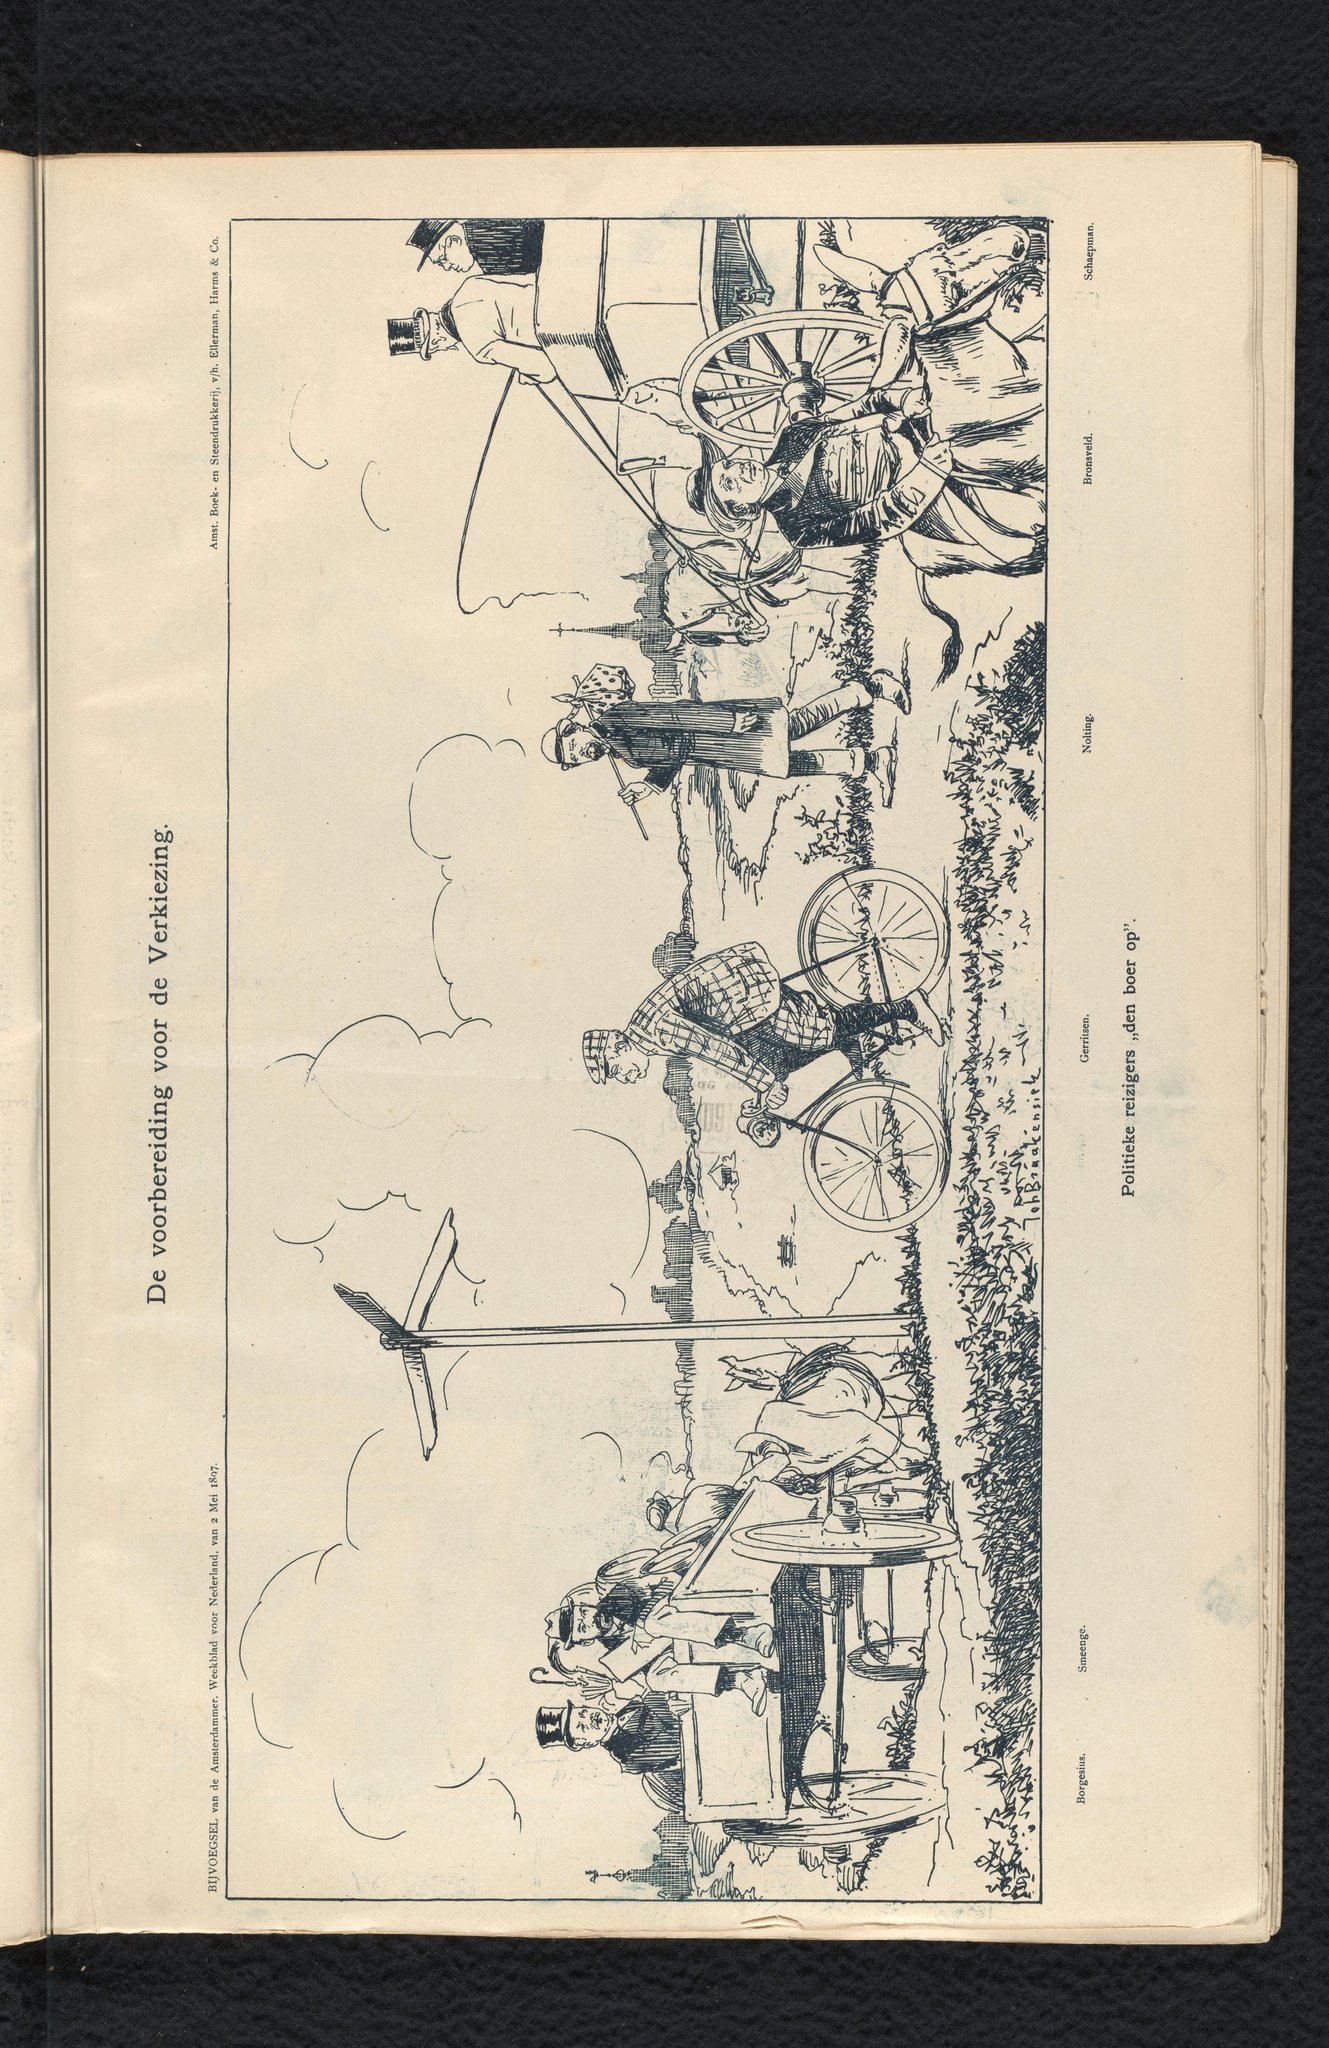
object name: cartoon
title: De voorbereiding voor de Verkiezing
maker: johan braakensiek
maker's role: draughtsman, print maker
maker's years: 1858-1940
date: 1897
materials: paper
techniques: lithograph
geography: netherlands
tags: political campaign, political caricatures and satires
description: Nederlandse politici gaan 'de boer op' in de campagne voor de Tweede Kamerverkiezingen van 1897.